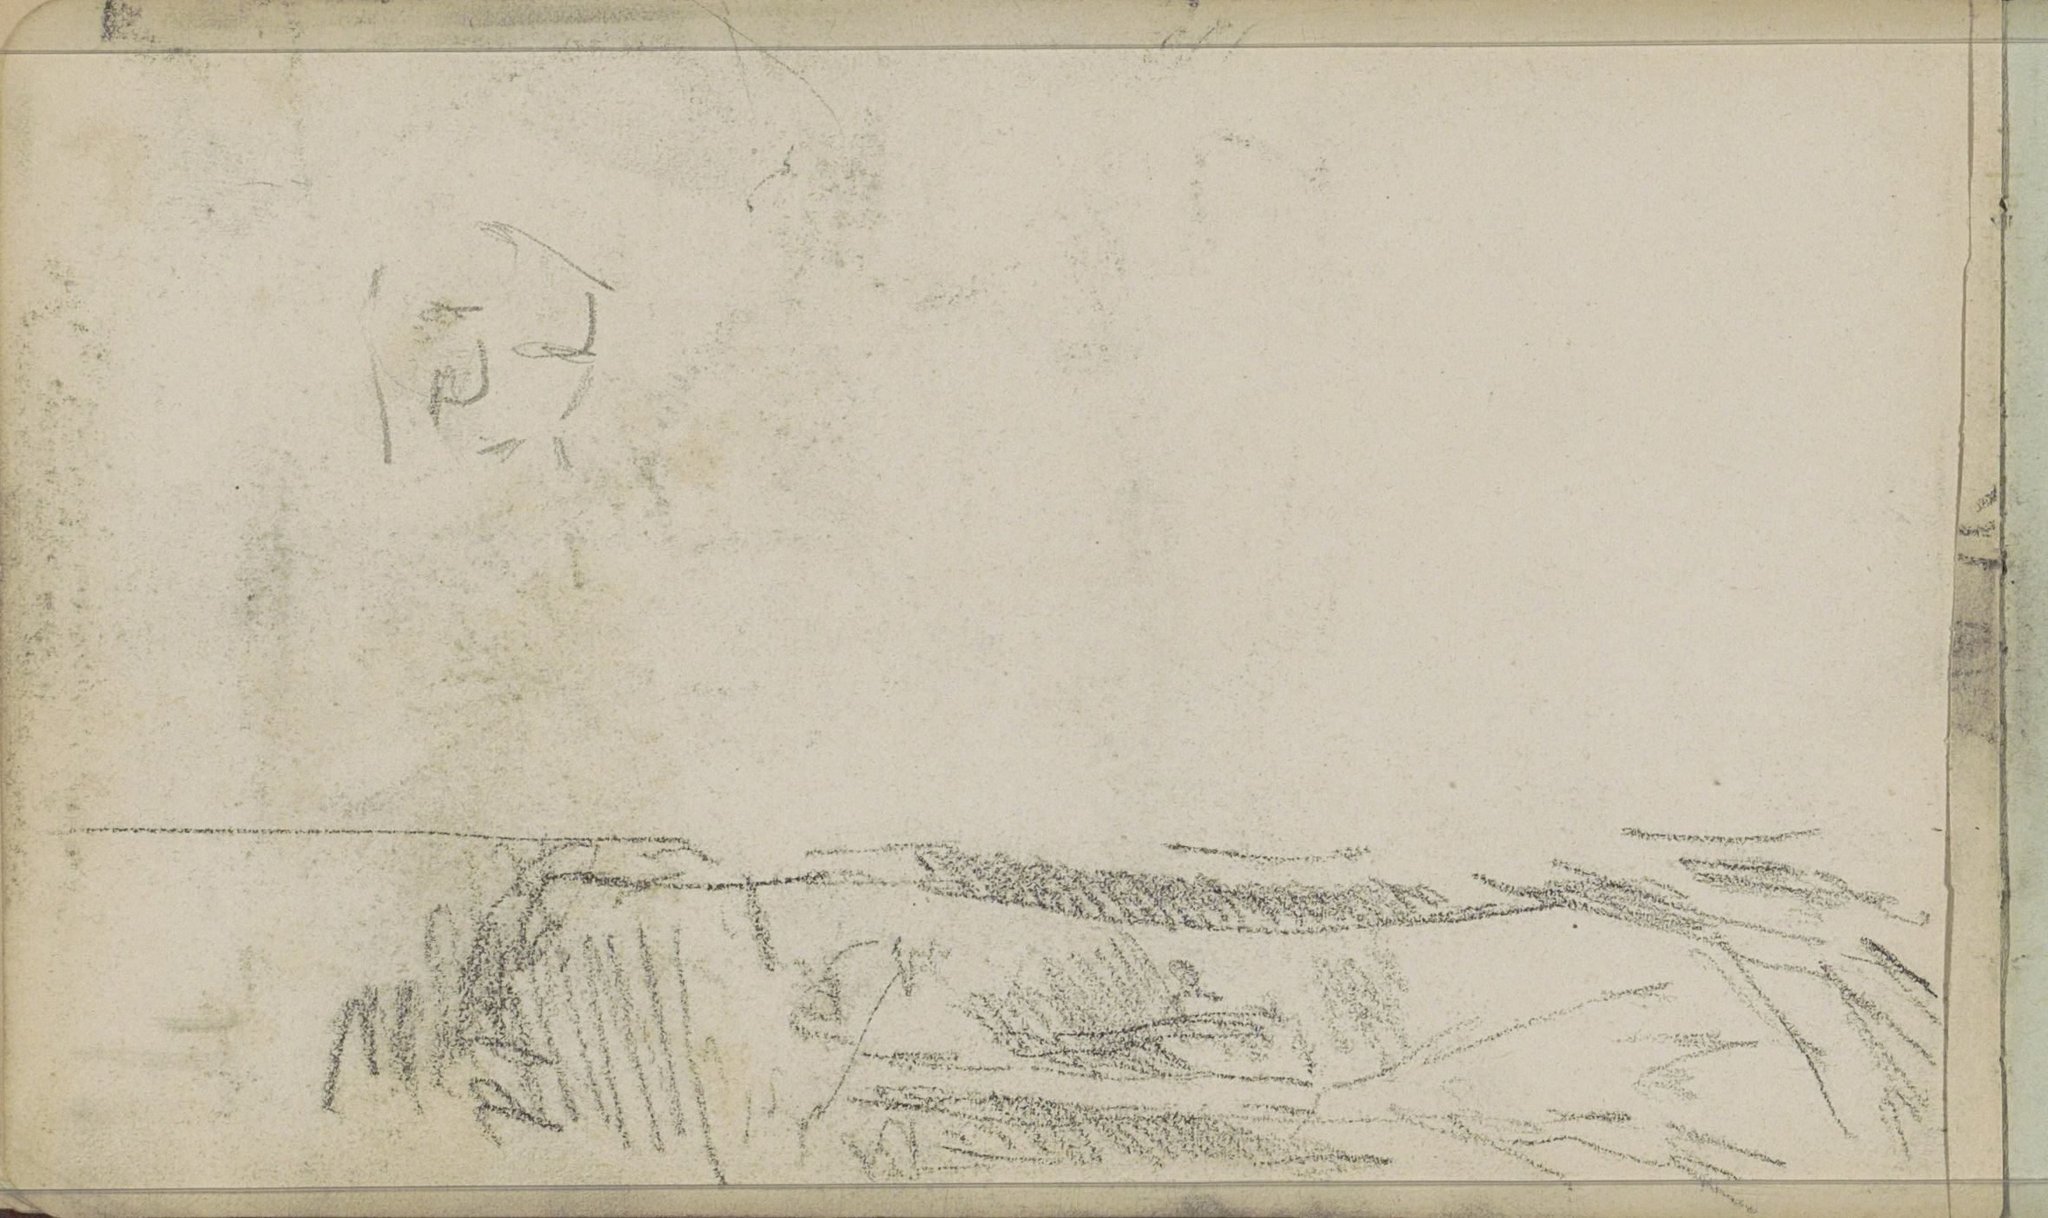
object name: sketchbook leaf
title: Studie, mogelijk van een landschap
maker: johan antonie de jonge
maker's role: draughtsman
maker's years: 1864-1927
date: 1881-1927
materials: chalk, paper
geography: south holland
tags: landscapes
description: Studie, mogelijk van een landschap. Blad 18 verso uit een schetsboek met 34 bladen.